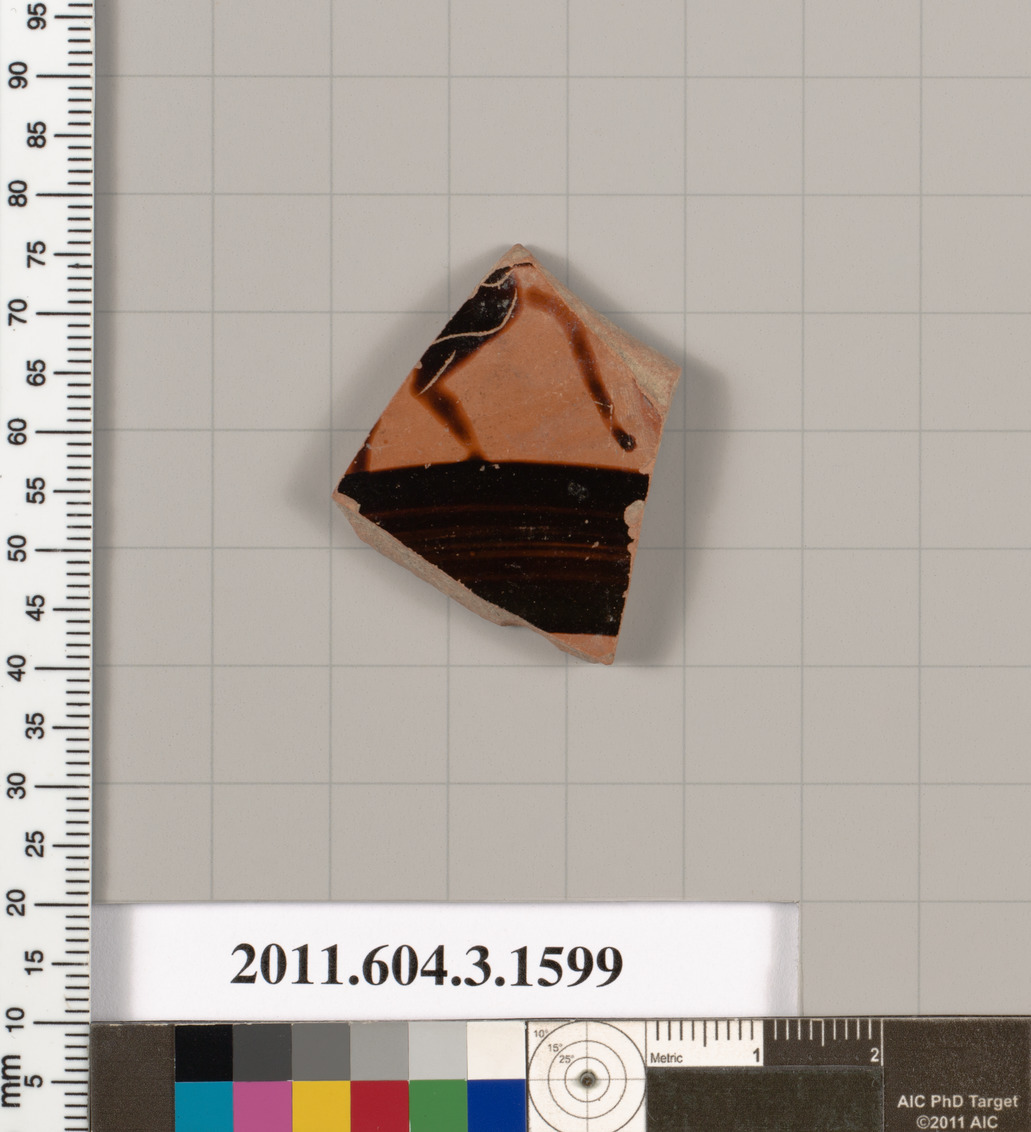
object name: kylix fragment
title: Terracotta fragment of a kylix: Band cup (drinking cup)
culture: greek, attic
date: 550-526 BCE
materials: terracotta